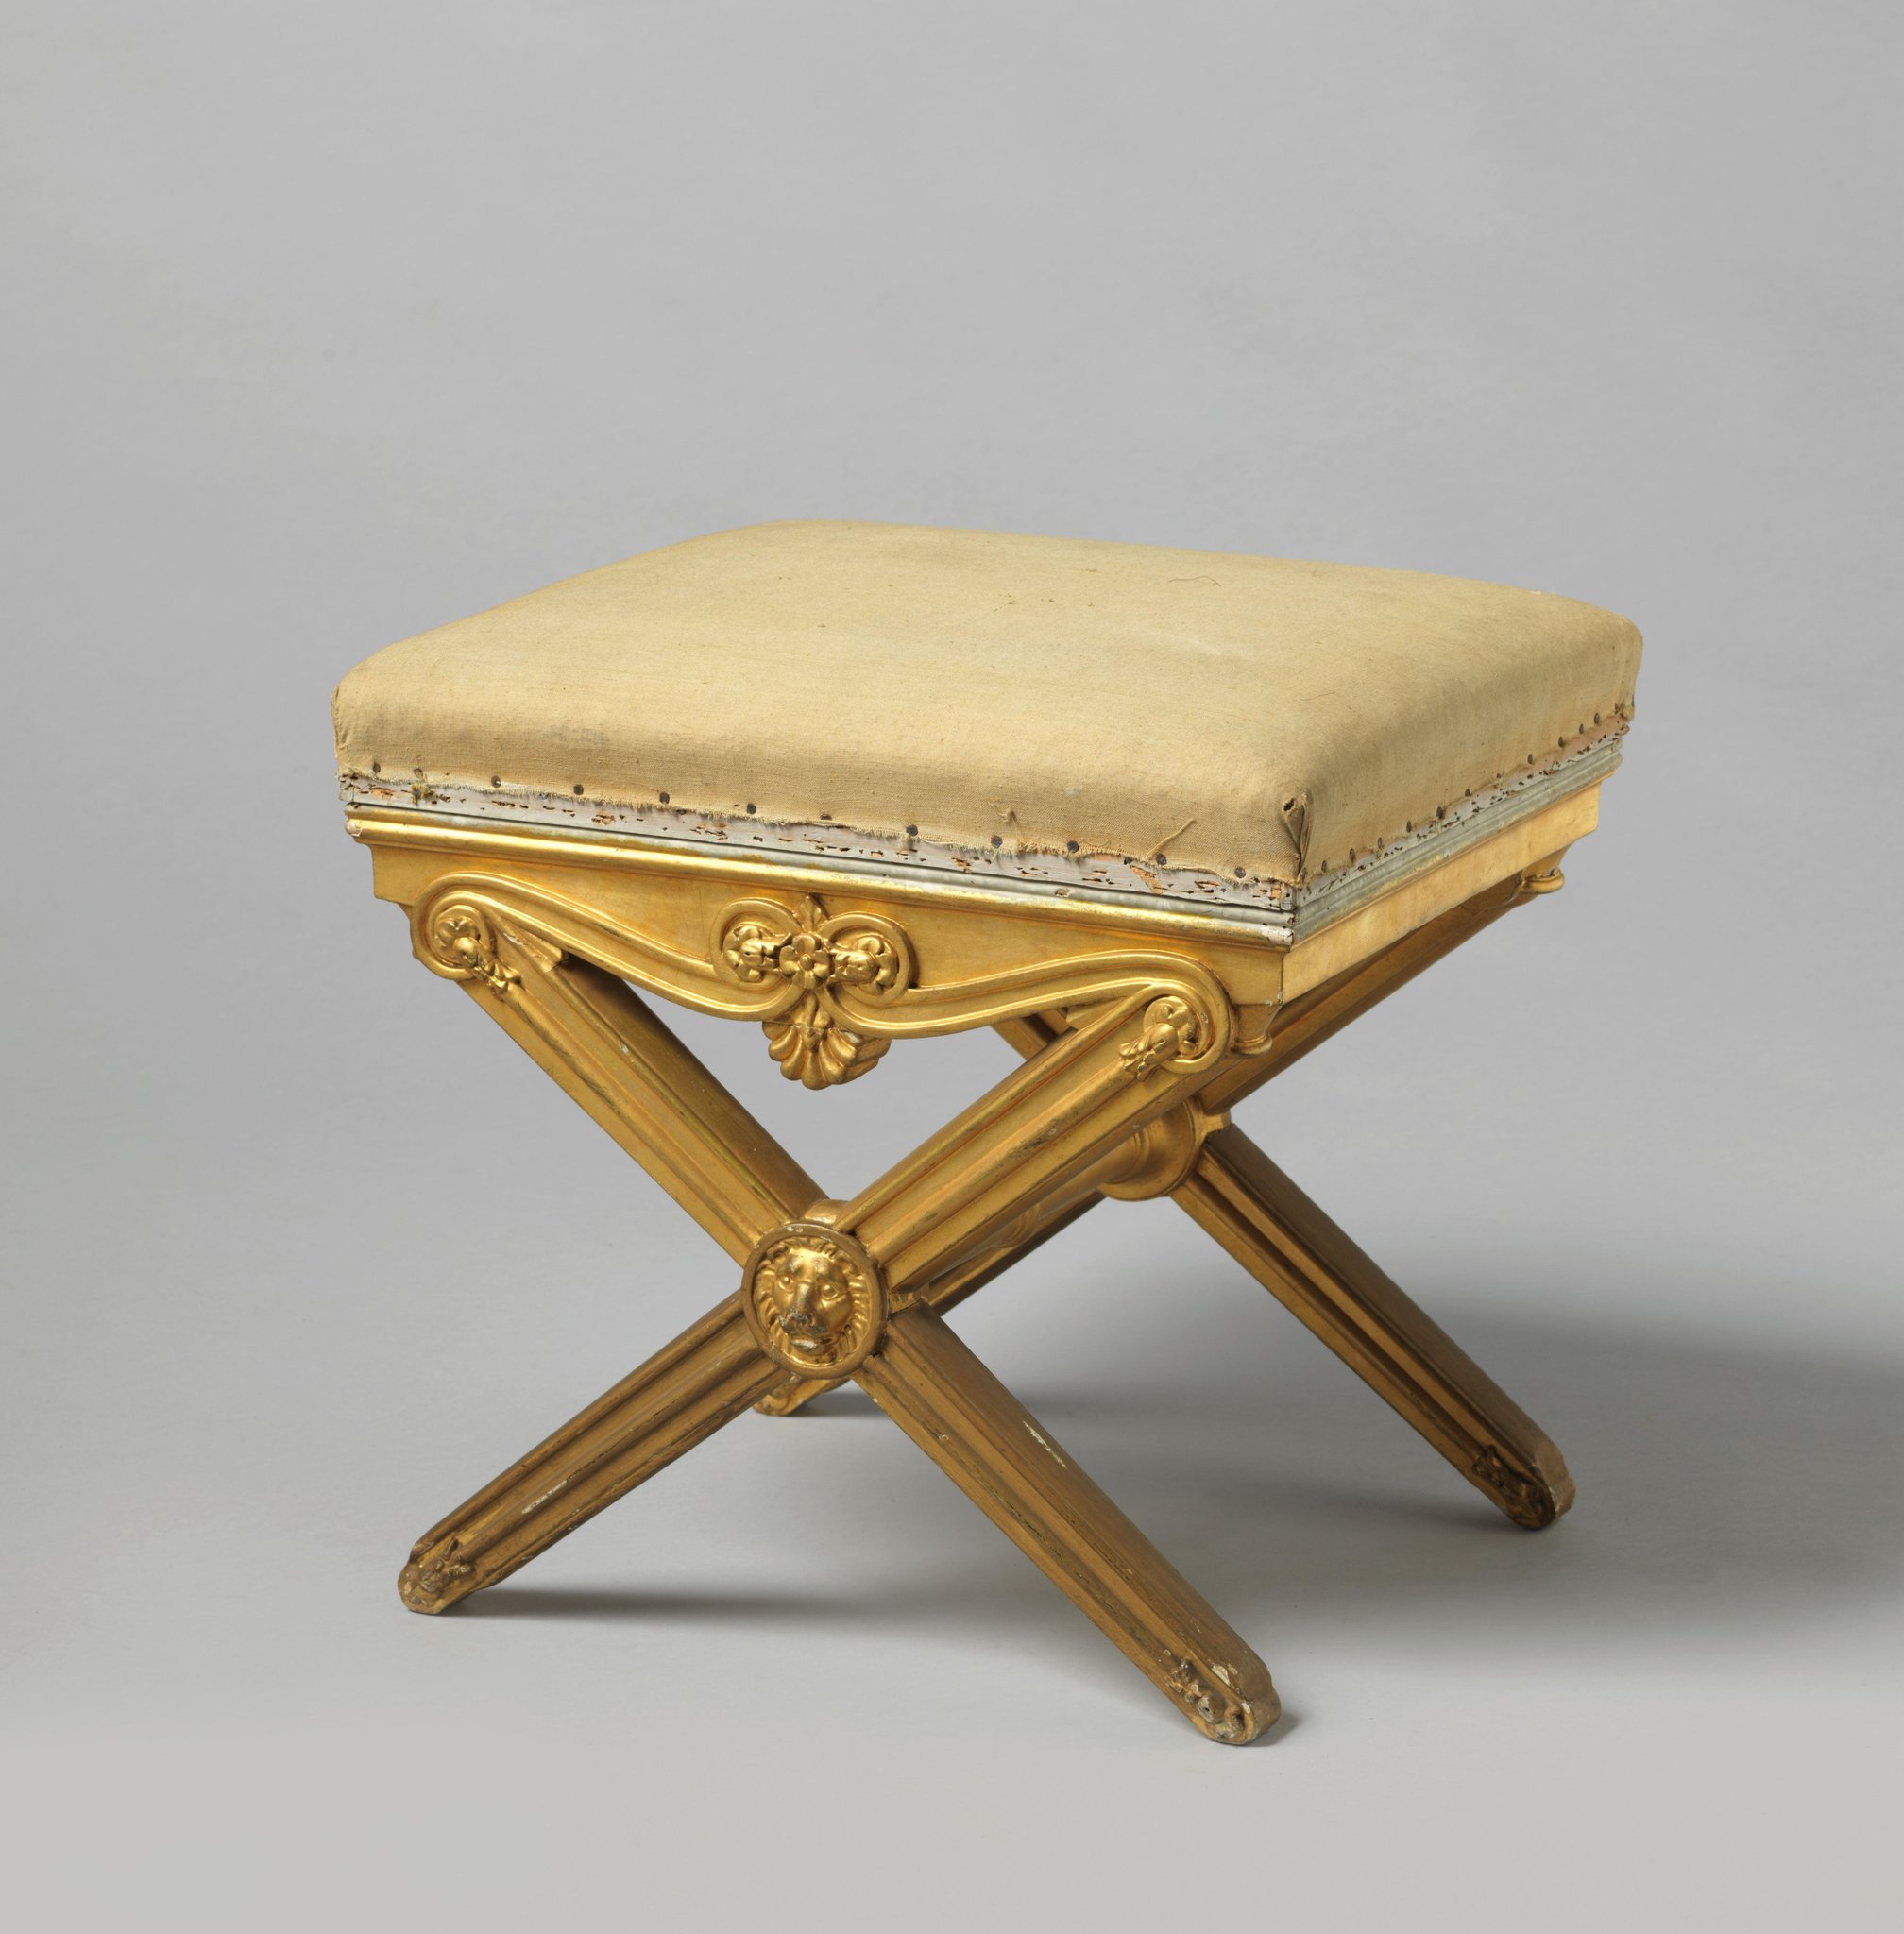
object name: tabouret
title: Taboeret van verguld iepenhout met kruispoten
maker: Anonymous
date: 1800-1825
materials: wood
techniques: gilding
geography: netherlands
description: Taboeret van verguld iepenhout met kruispoten (vorm van vouwstoel) en een los kussen.